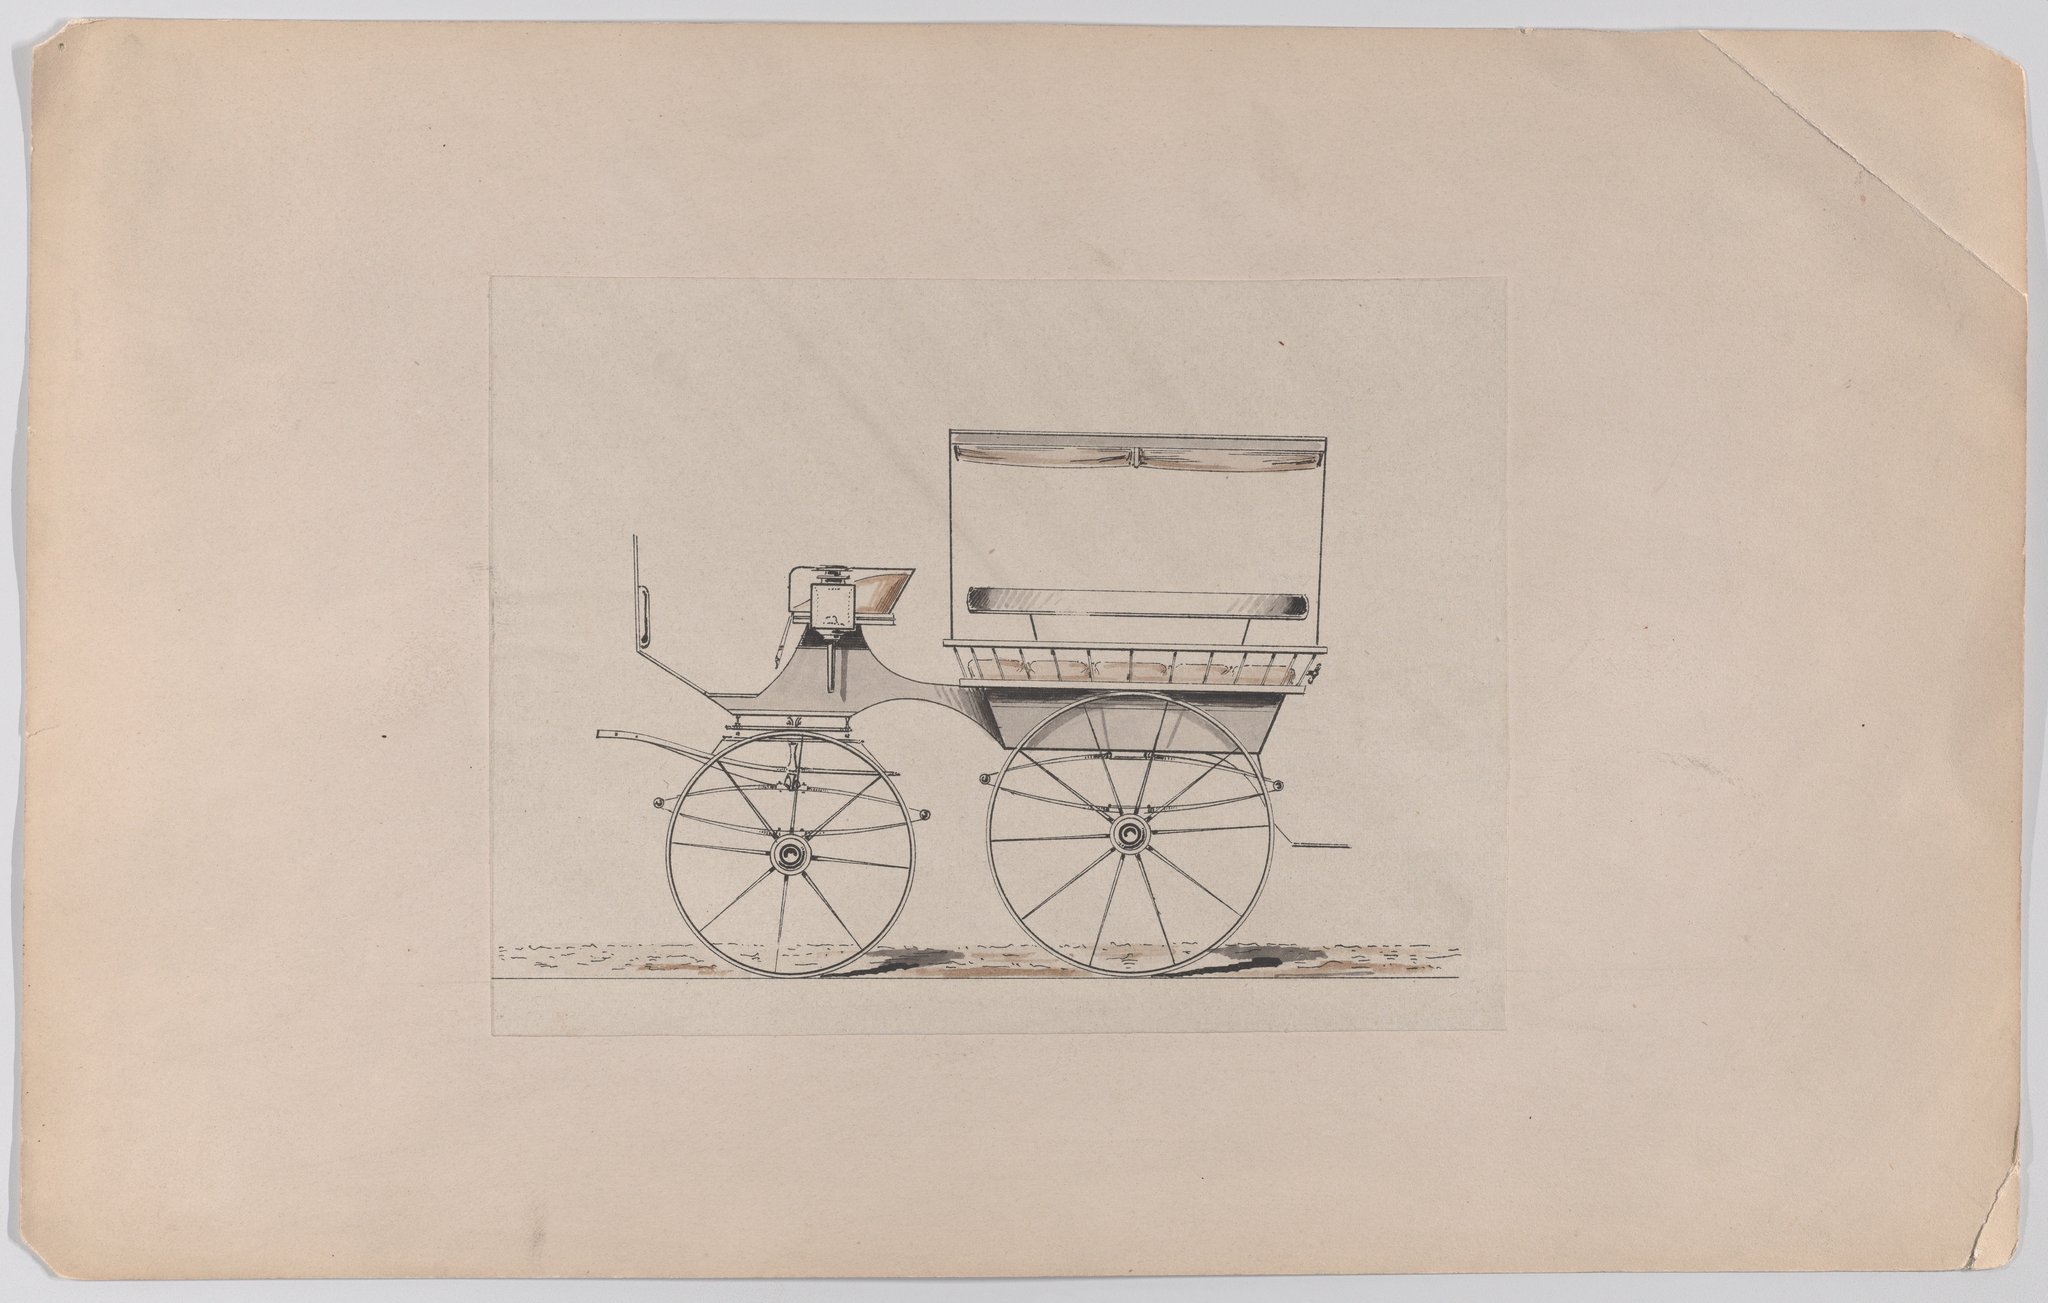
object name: drawing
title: Design for Wagonette with Canopy Top (unnumbered)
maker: brewster & co.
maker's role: manufacturer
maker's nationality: american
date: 1880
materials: gouache, ink, watercolor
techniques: pen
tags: carriages